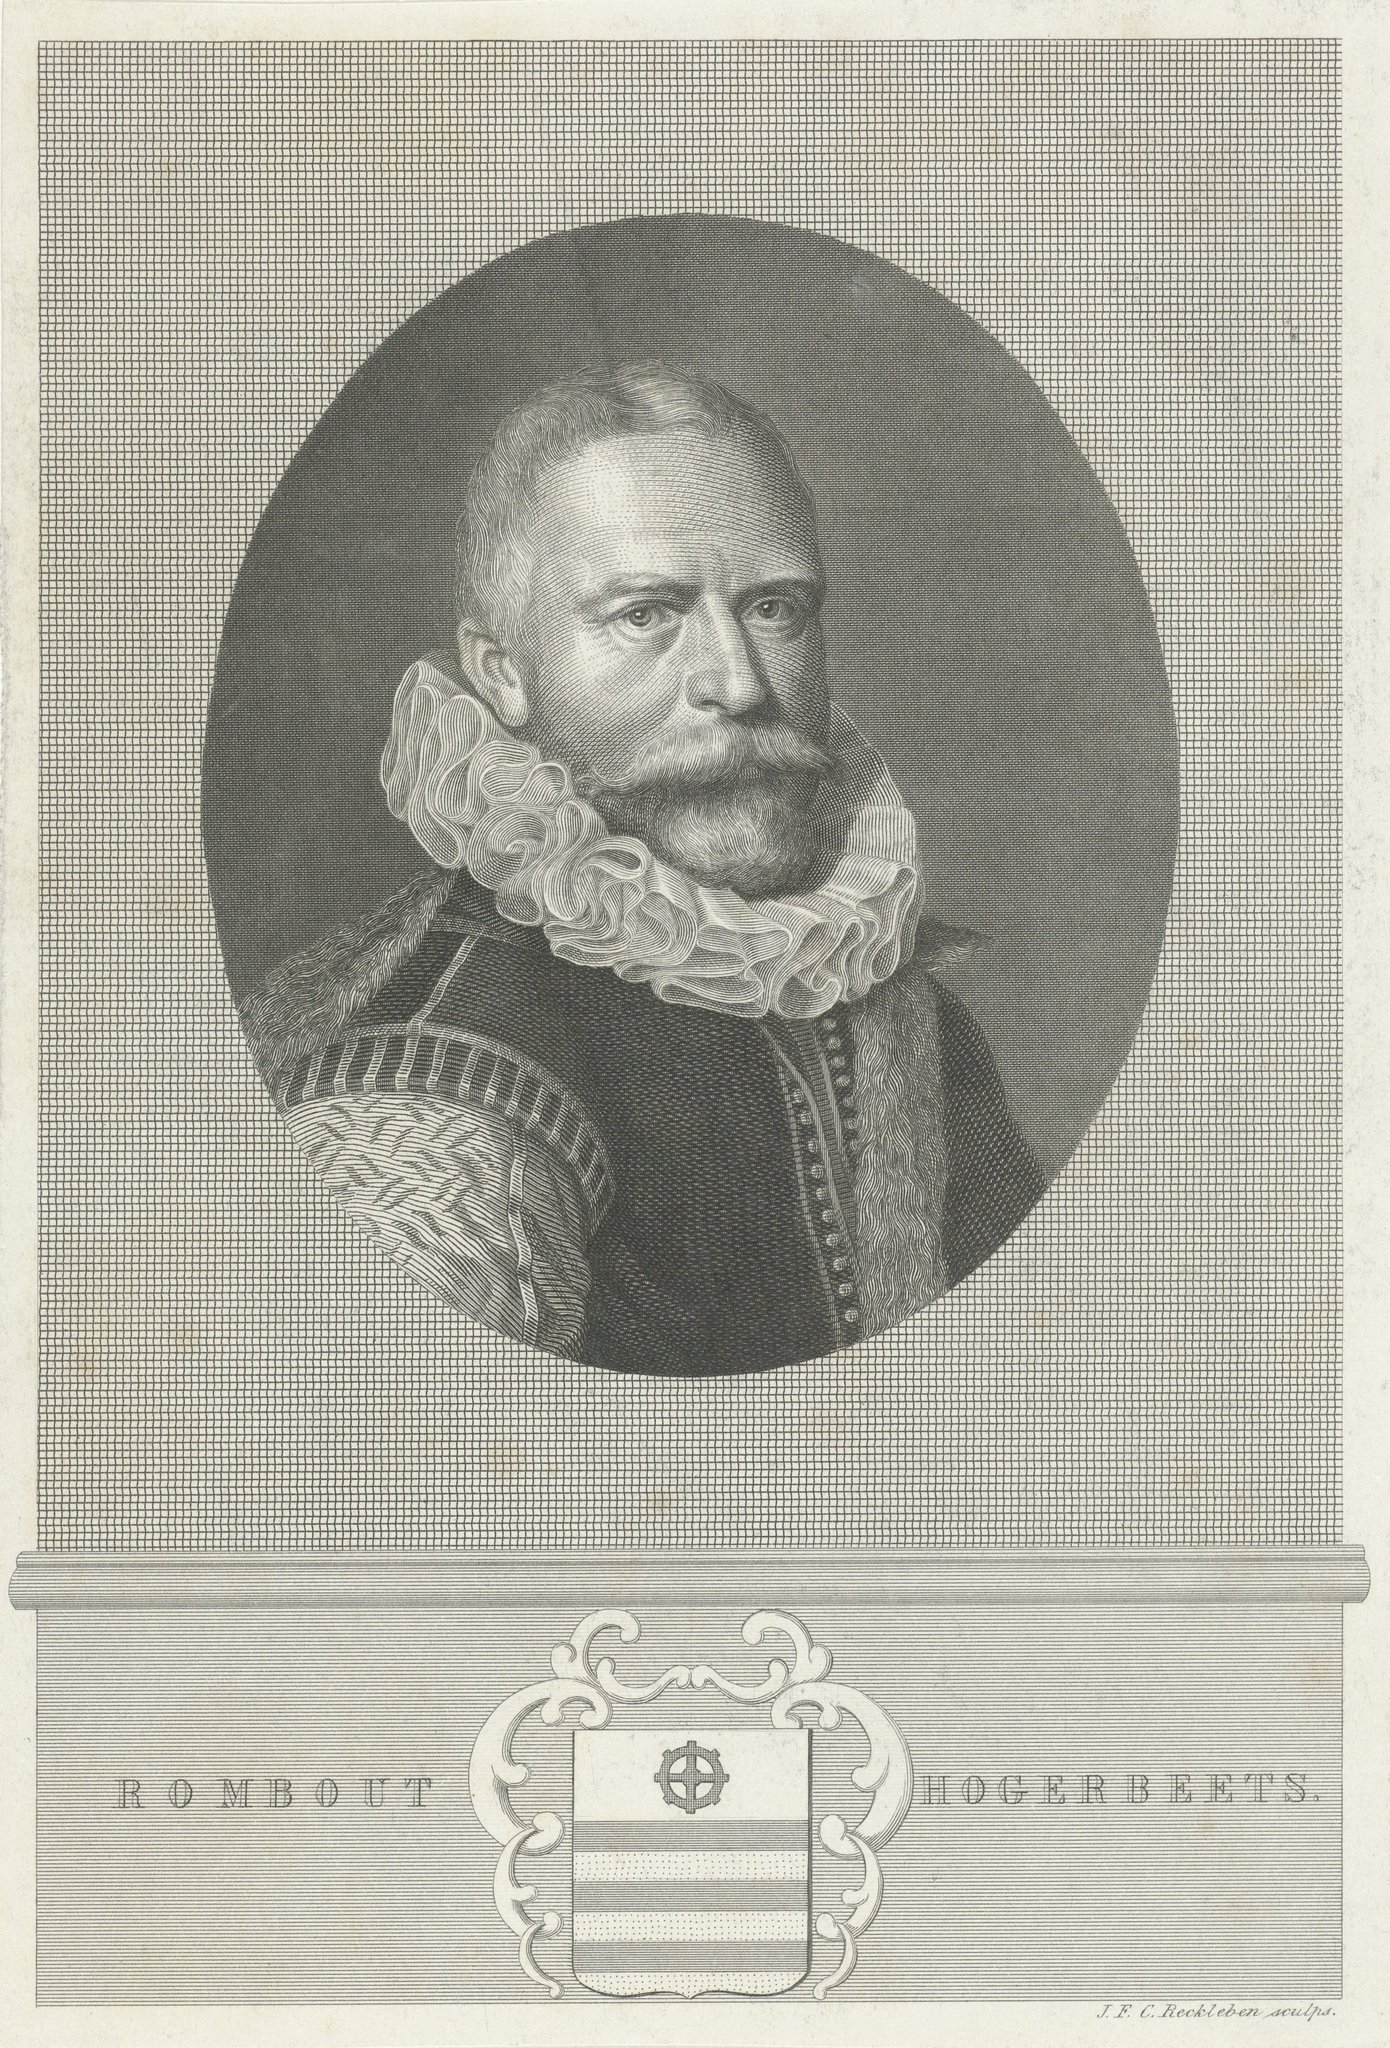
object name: print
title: Portret van Rombout Hogerbeets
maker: jan frederik christiaan reckleben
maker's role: print maker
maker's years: 1819-1879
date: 1855-1857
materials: paper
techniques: engraving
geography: amsterdam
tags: hoorn (north holland)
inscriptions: collector's mark: Lugt 2228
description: Illustratie in: Arend, Johannes Pieter. Algemeene geschiedenis des vaderlands van de vroegste tijden tot op heden. 5 delen, Amsterdam: Schleijer, J.F. 1840-1884, dl. 3.2, p. 767.